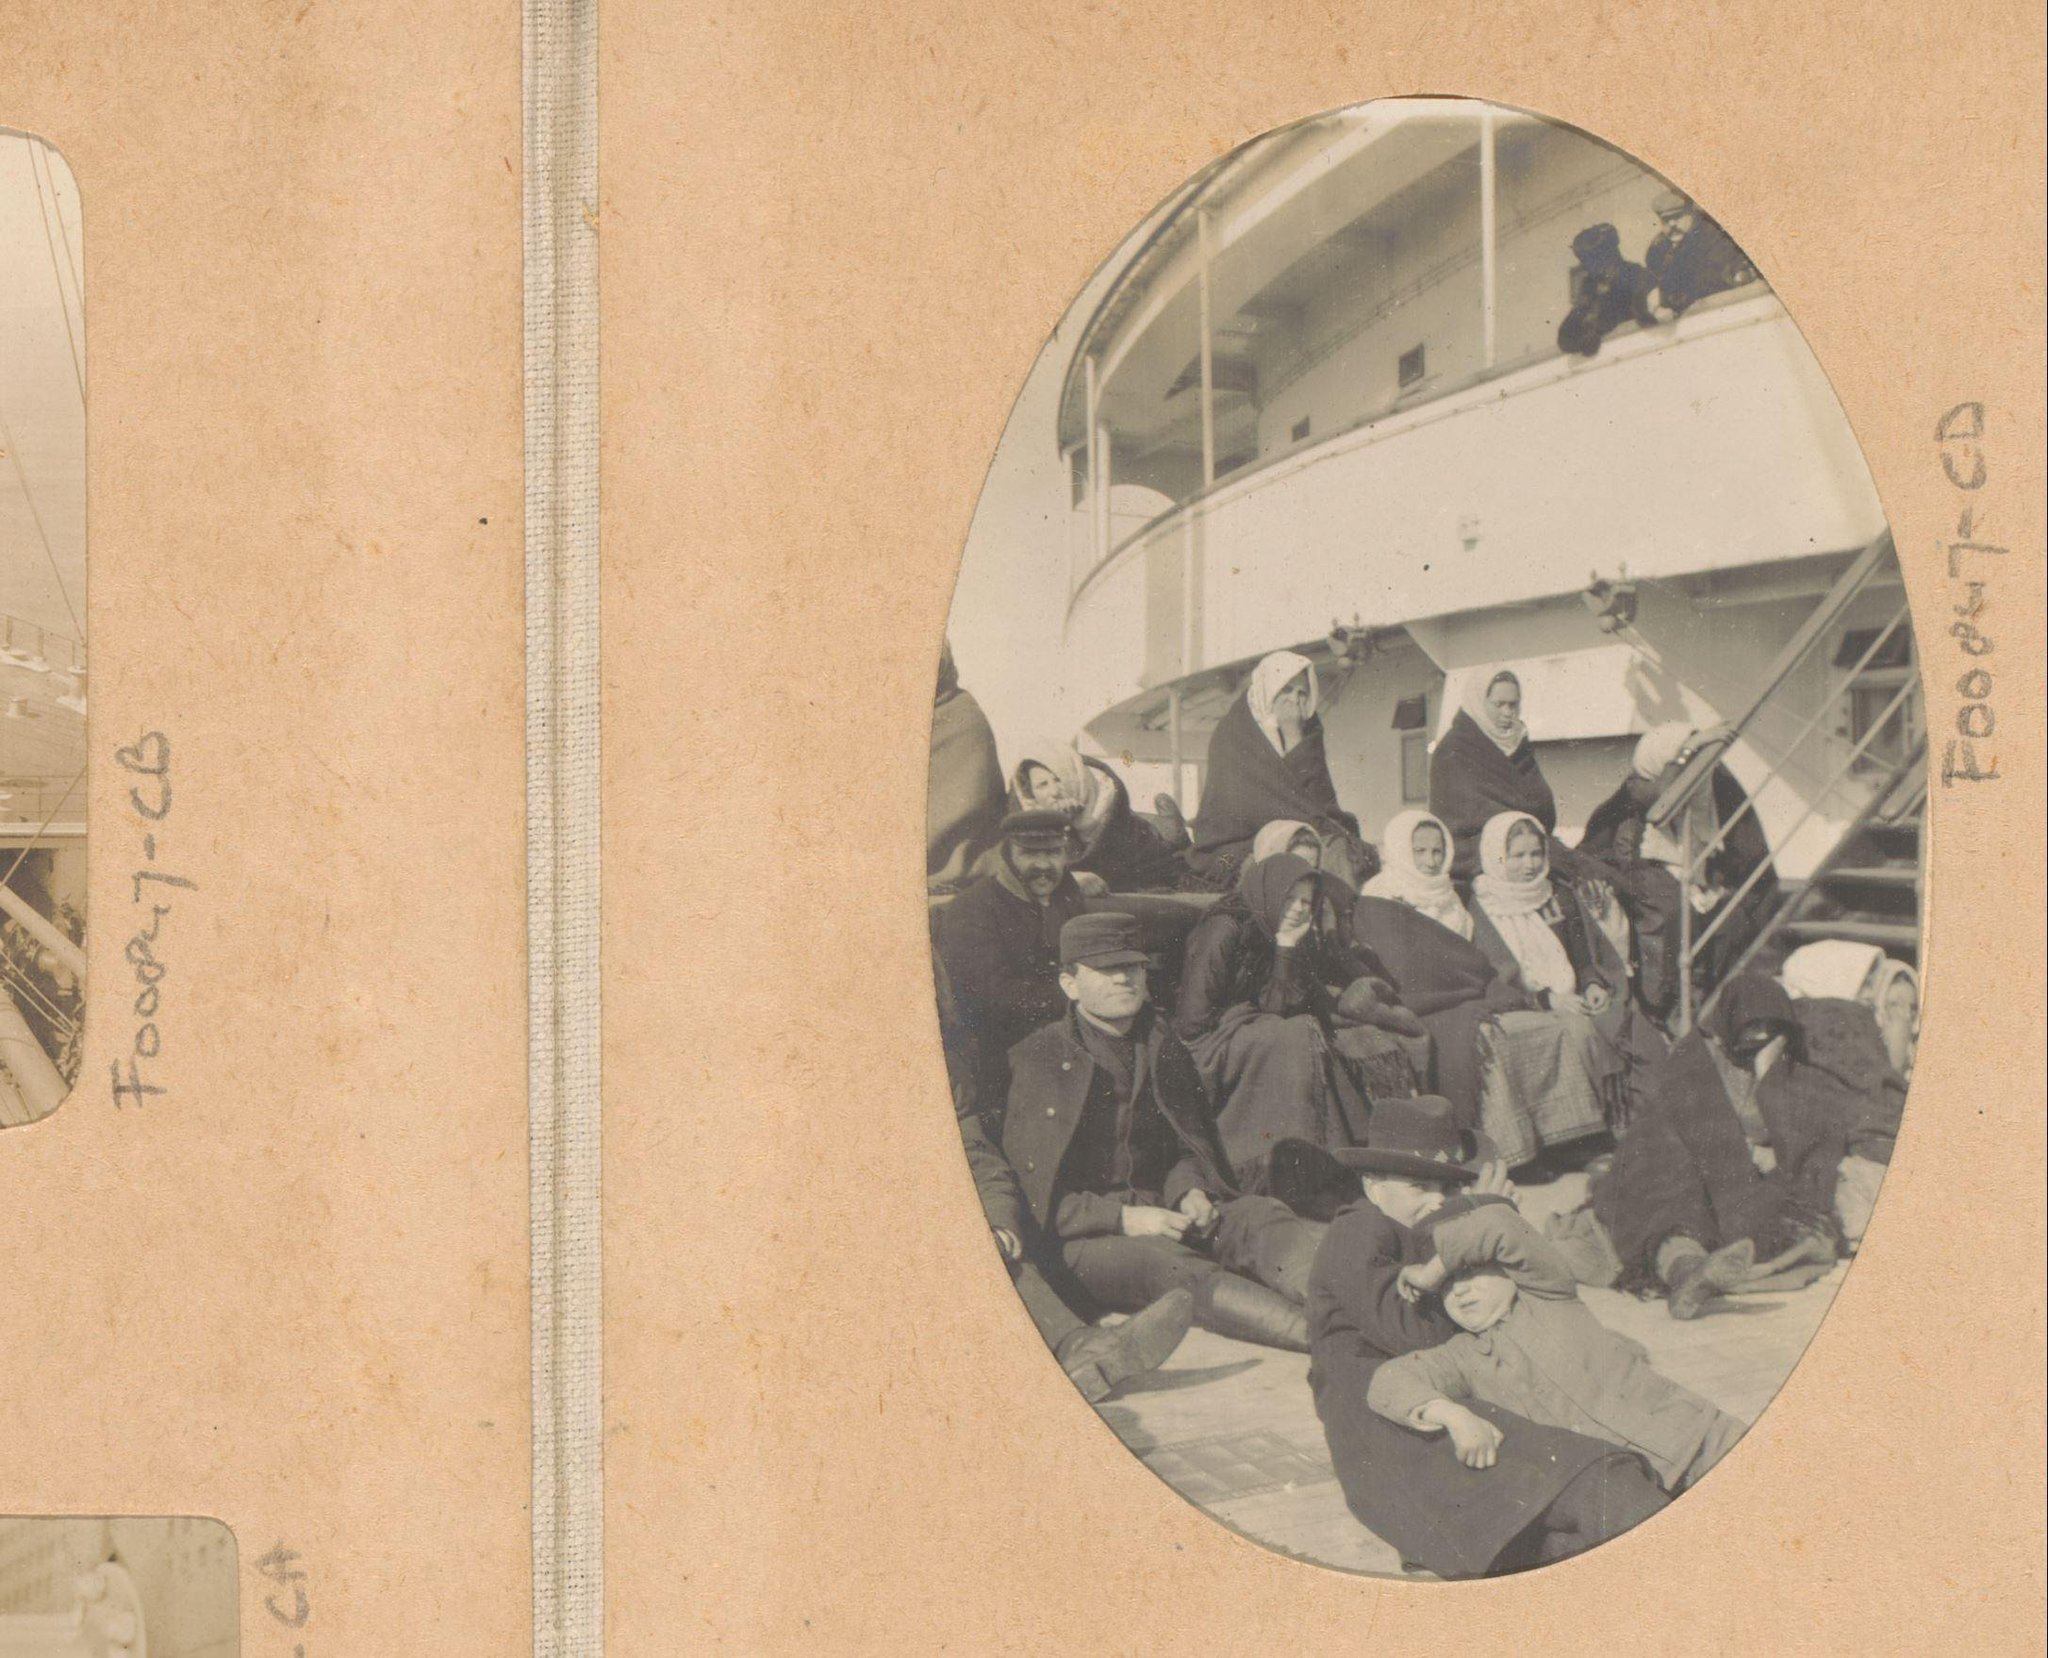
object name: photograph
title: Groep mensen aan boord van een schip, mogelijk landverhuizers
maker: Anonymous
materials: cardboard, paper, photographic support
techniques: gelatin silver print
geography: atlantic ocean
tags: passenger liner (+ view ~ vehicle, ship, etc.), migrants, passengers ~ ship, atlantic ocean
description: Onderdeel van Reisalbum van een Nederlandse familie met bezienswaardigheden in Europa, Egypte en New York.